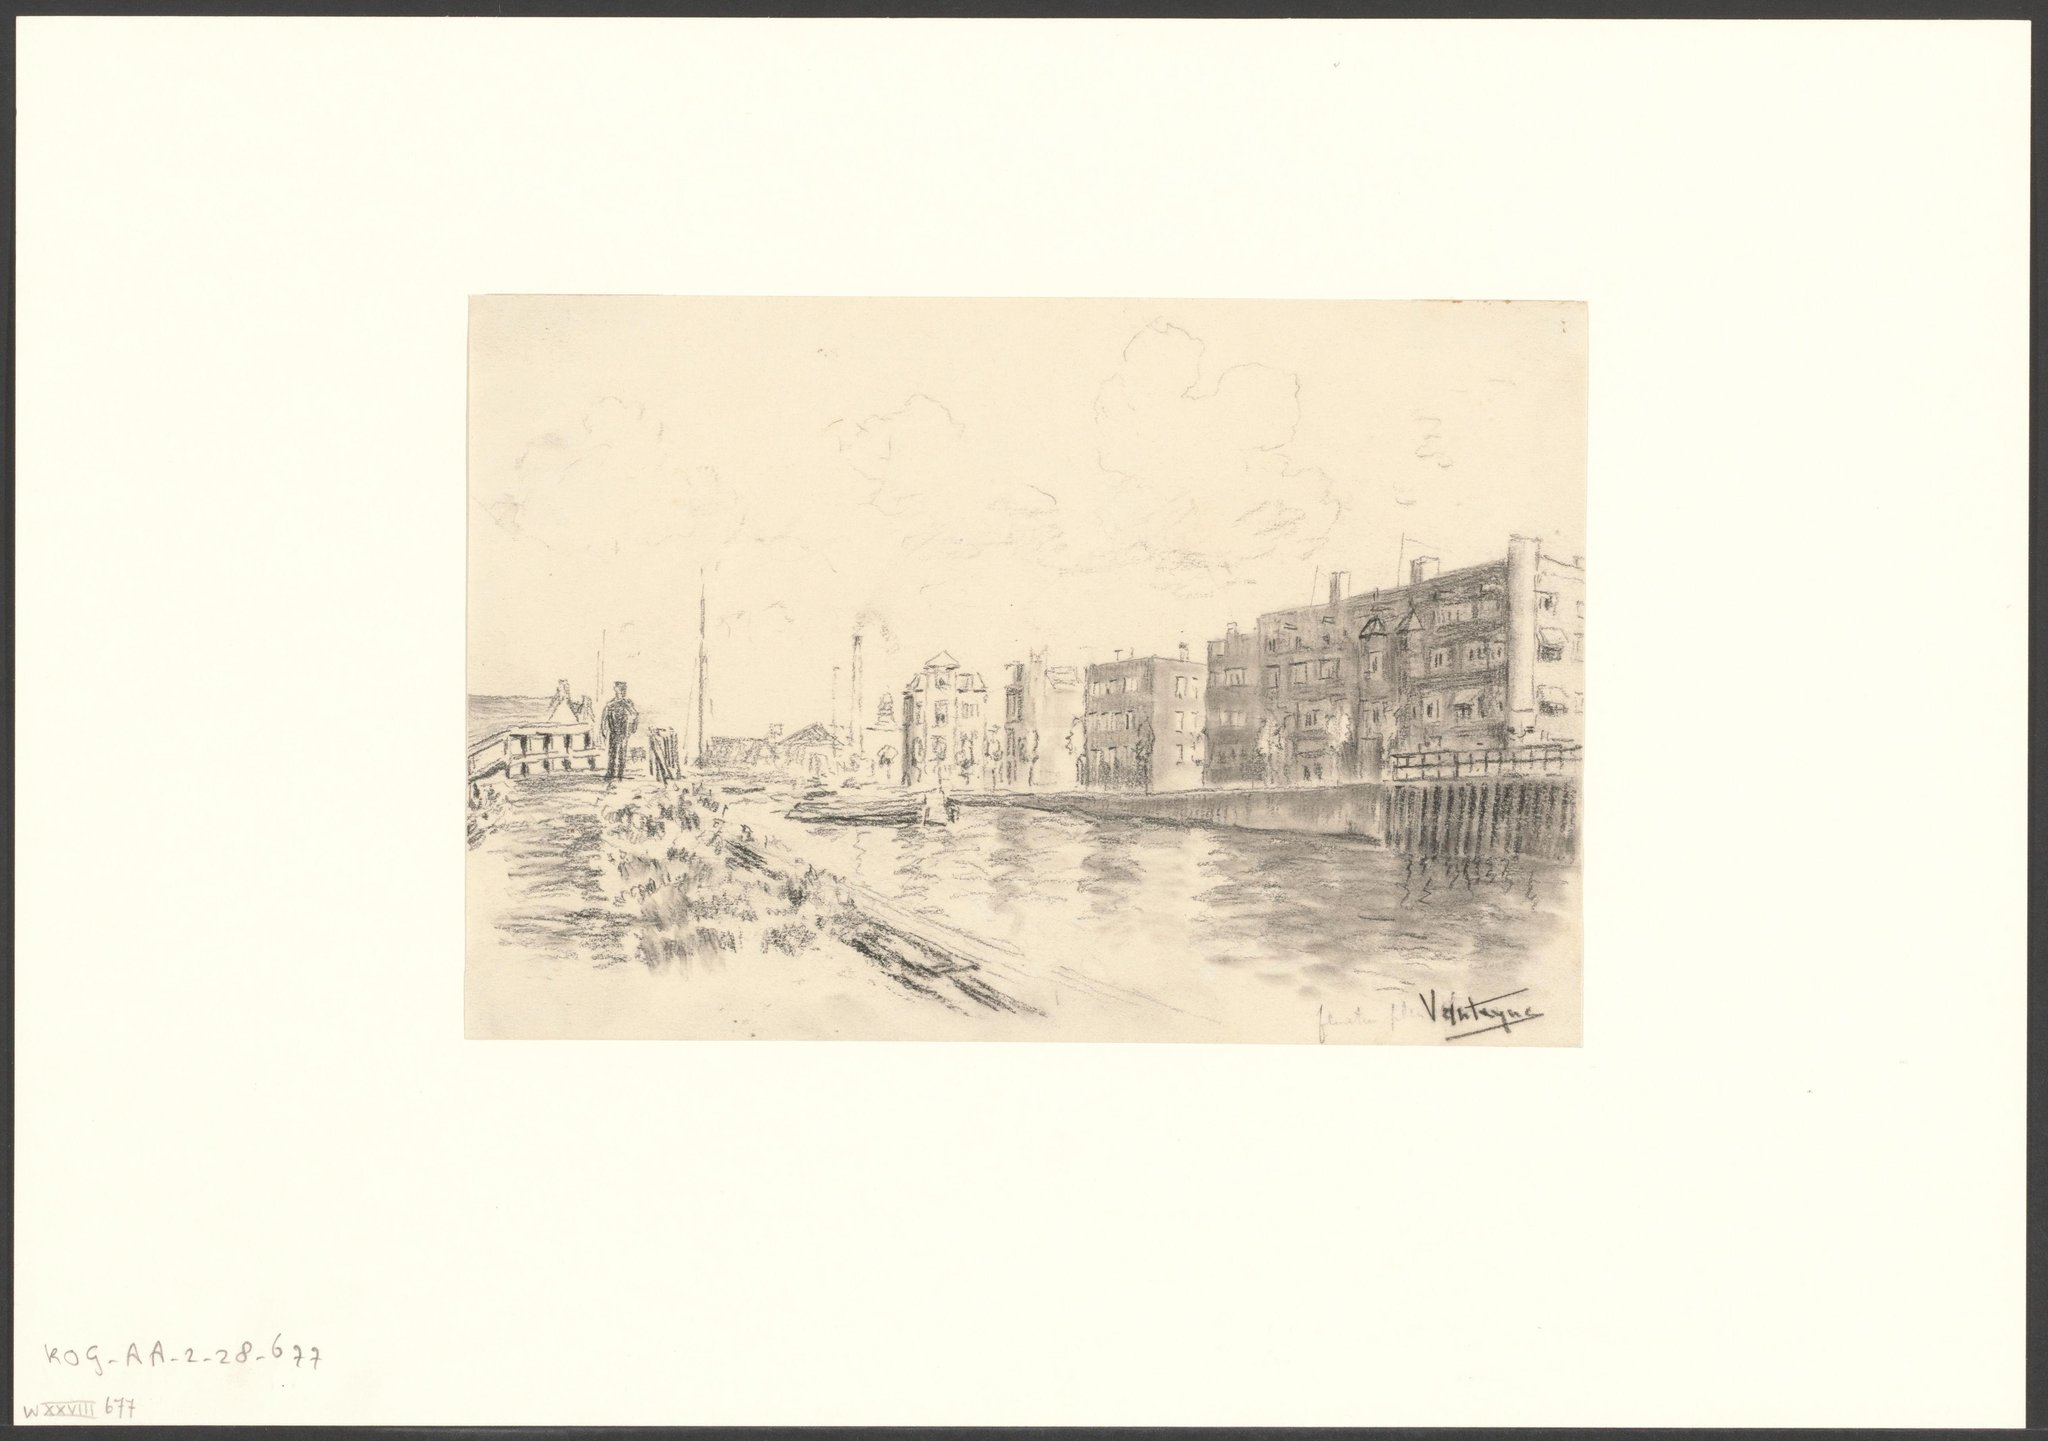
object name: drawing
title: Gezicht op de Kostverlorenvaart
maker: anthonie van teijn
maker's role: draughtsman, painter, print maker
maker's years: 1863-1943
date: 1907-1927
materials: chalk, paper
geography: amsterdam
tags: city-view in general; 'veduta', canal, bridge in city across river, canal, etc.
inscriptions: signature: ‘VanTeyne’, inscription: ‘De Kostverloren vaart (...) Juli 1927. / VanEck’, collector's mark: Lugt 800a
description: Tekening binnen de Atlas Van Eck ingedeeld op wijknummer 28.